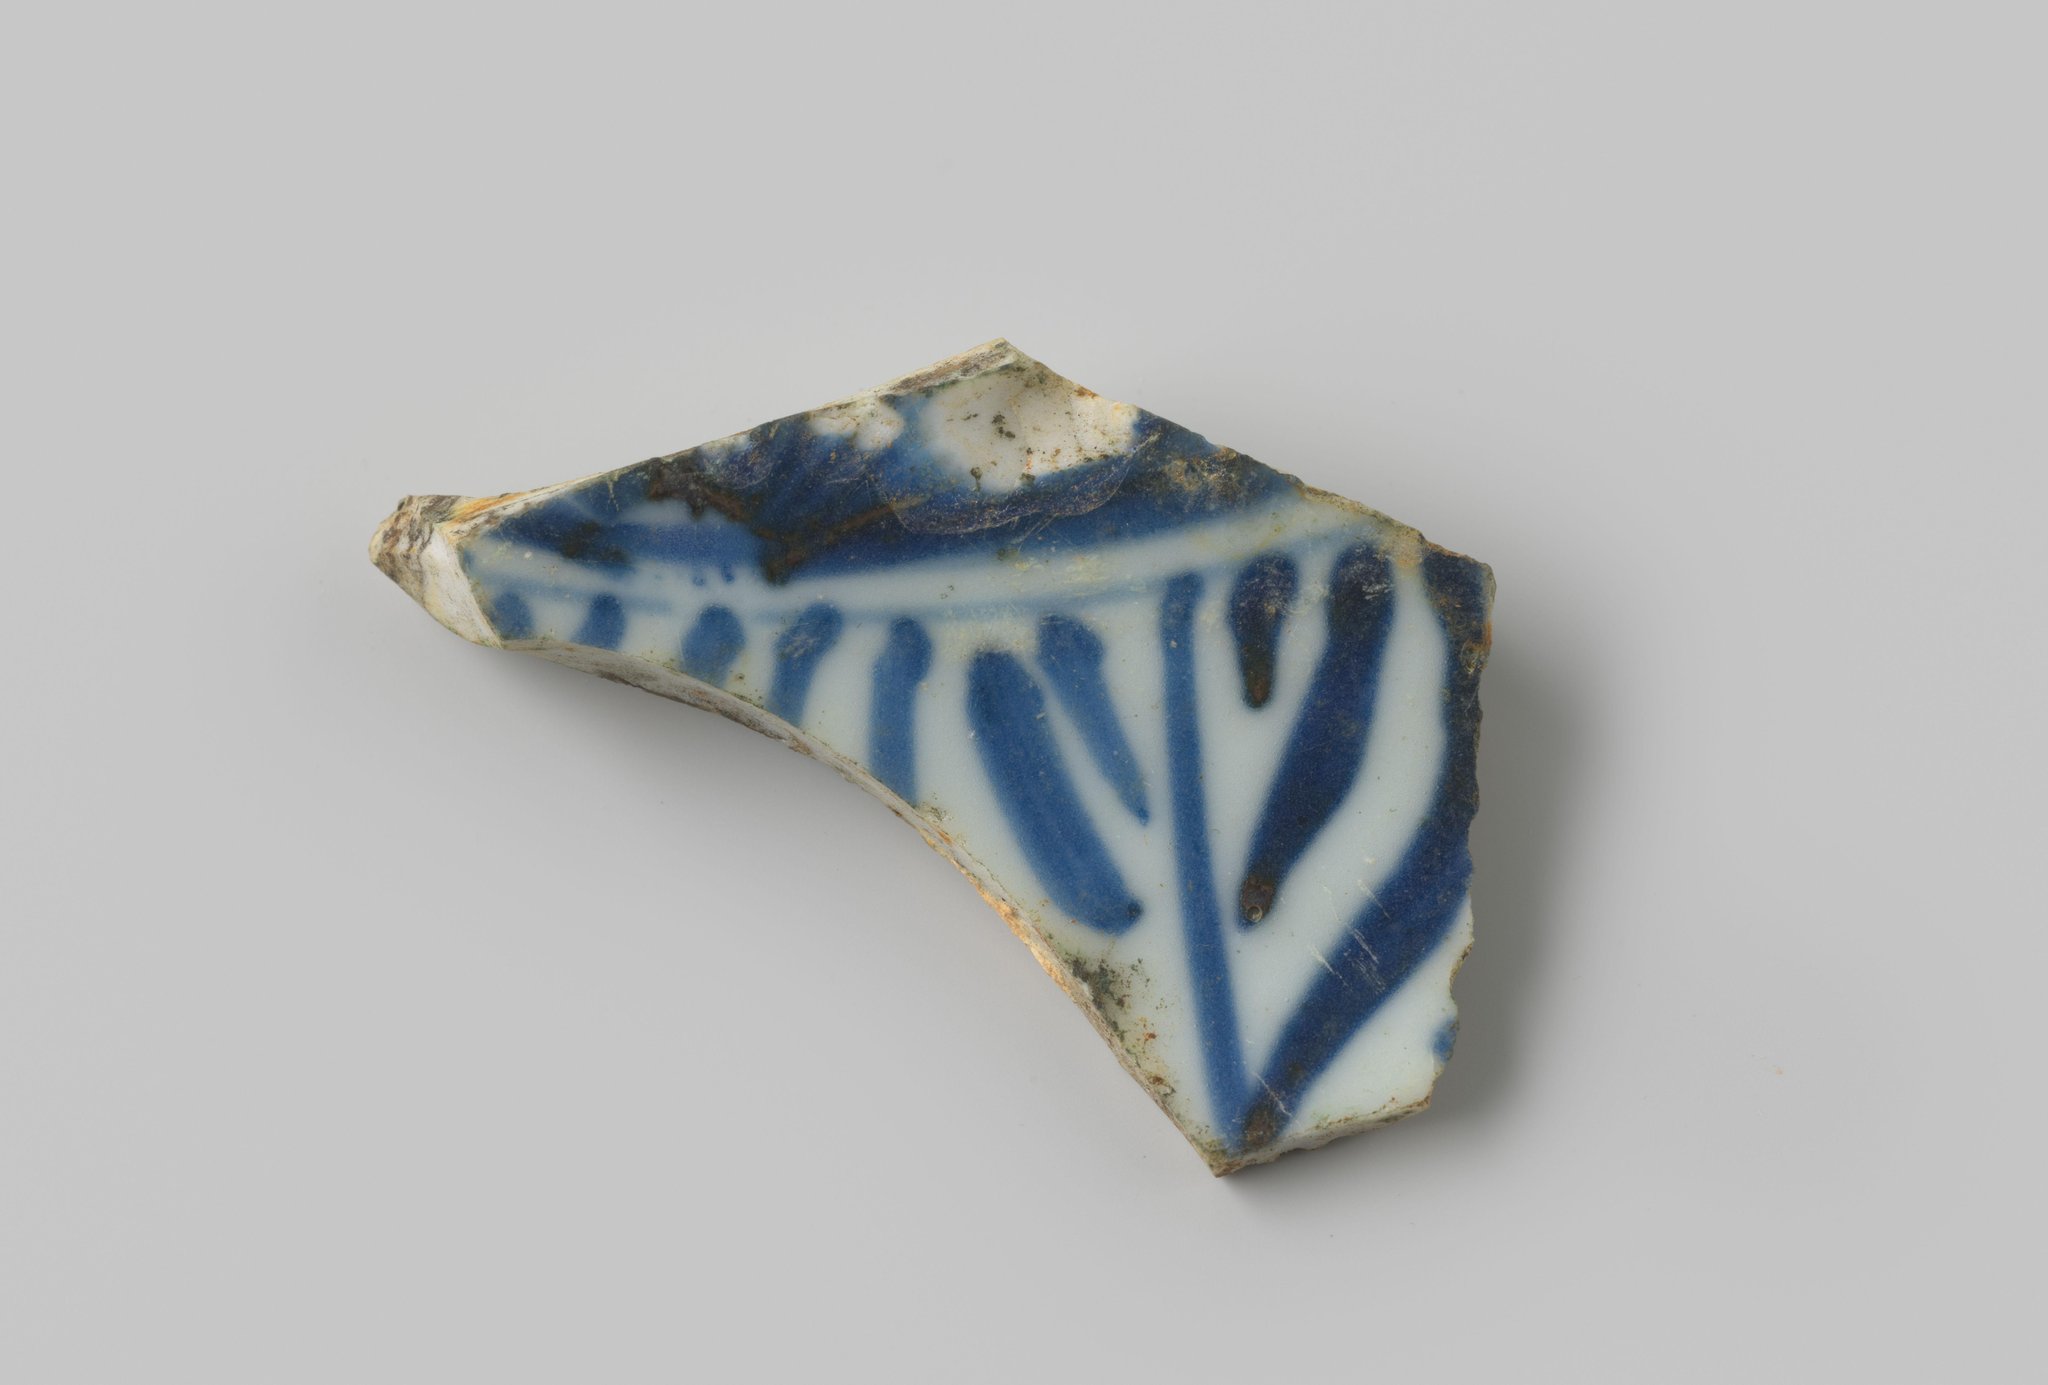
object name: sherd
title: Scherf van een schotel uit het wrak van de Oost-Indiëvaarder Hollandia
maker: Anonymous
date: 1700-1743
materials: porcelain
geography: netherlands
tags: verenigde oostindische compagnie, hollandia (schip), annet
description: Porcelain, dish, fragment; fragm of base, flat, with circular footring, decorated inside.